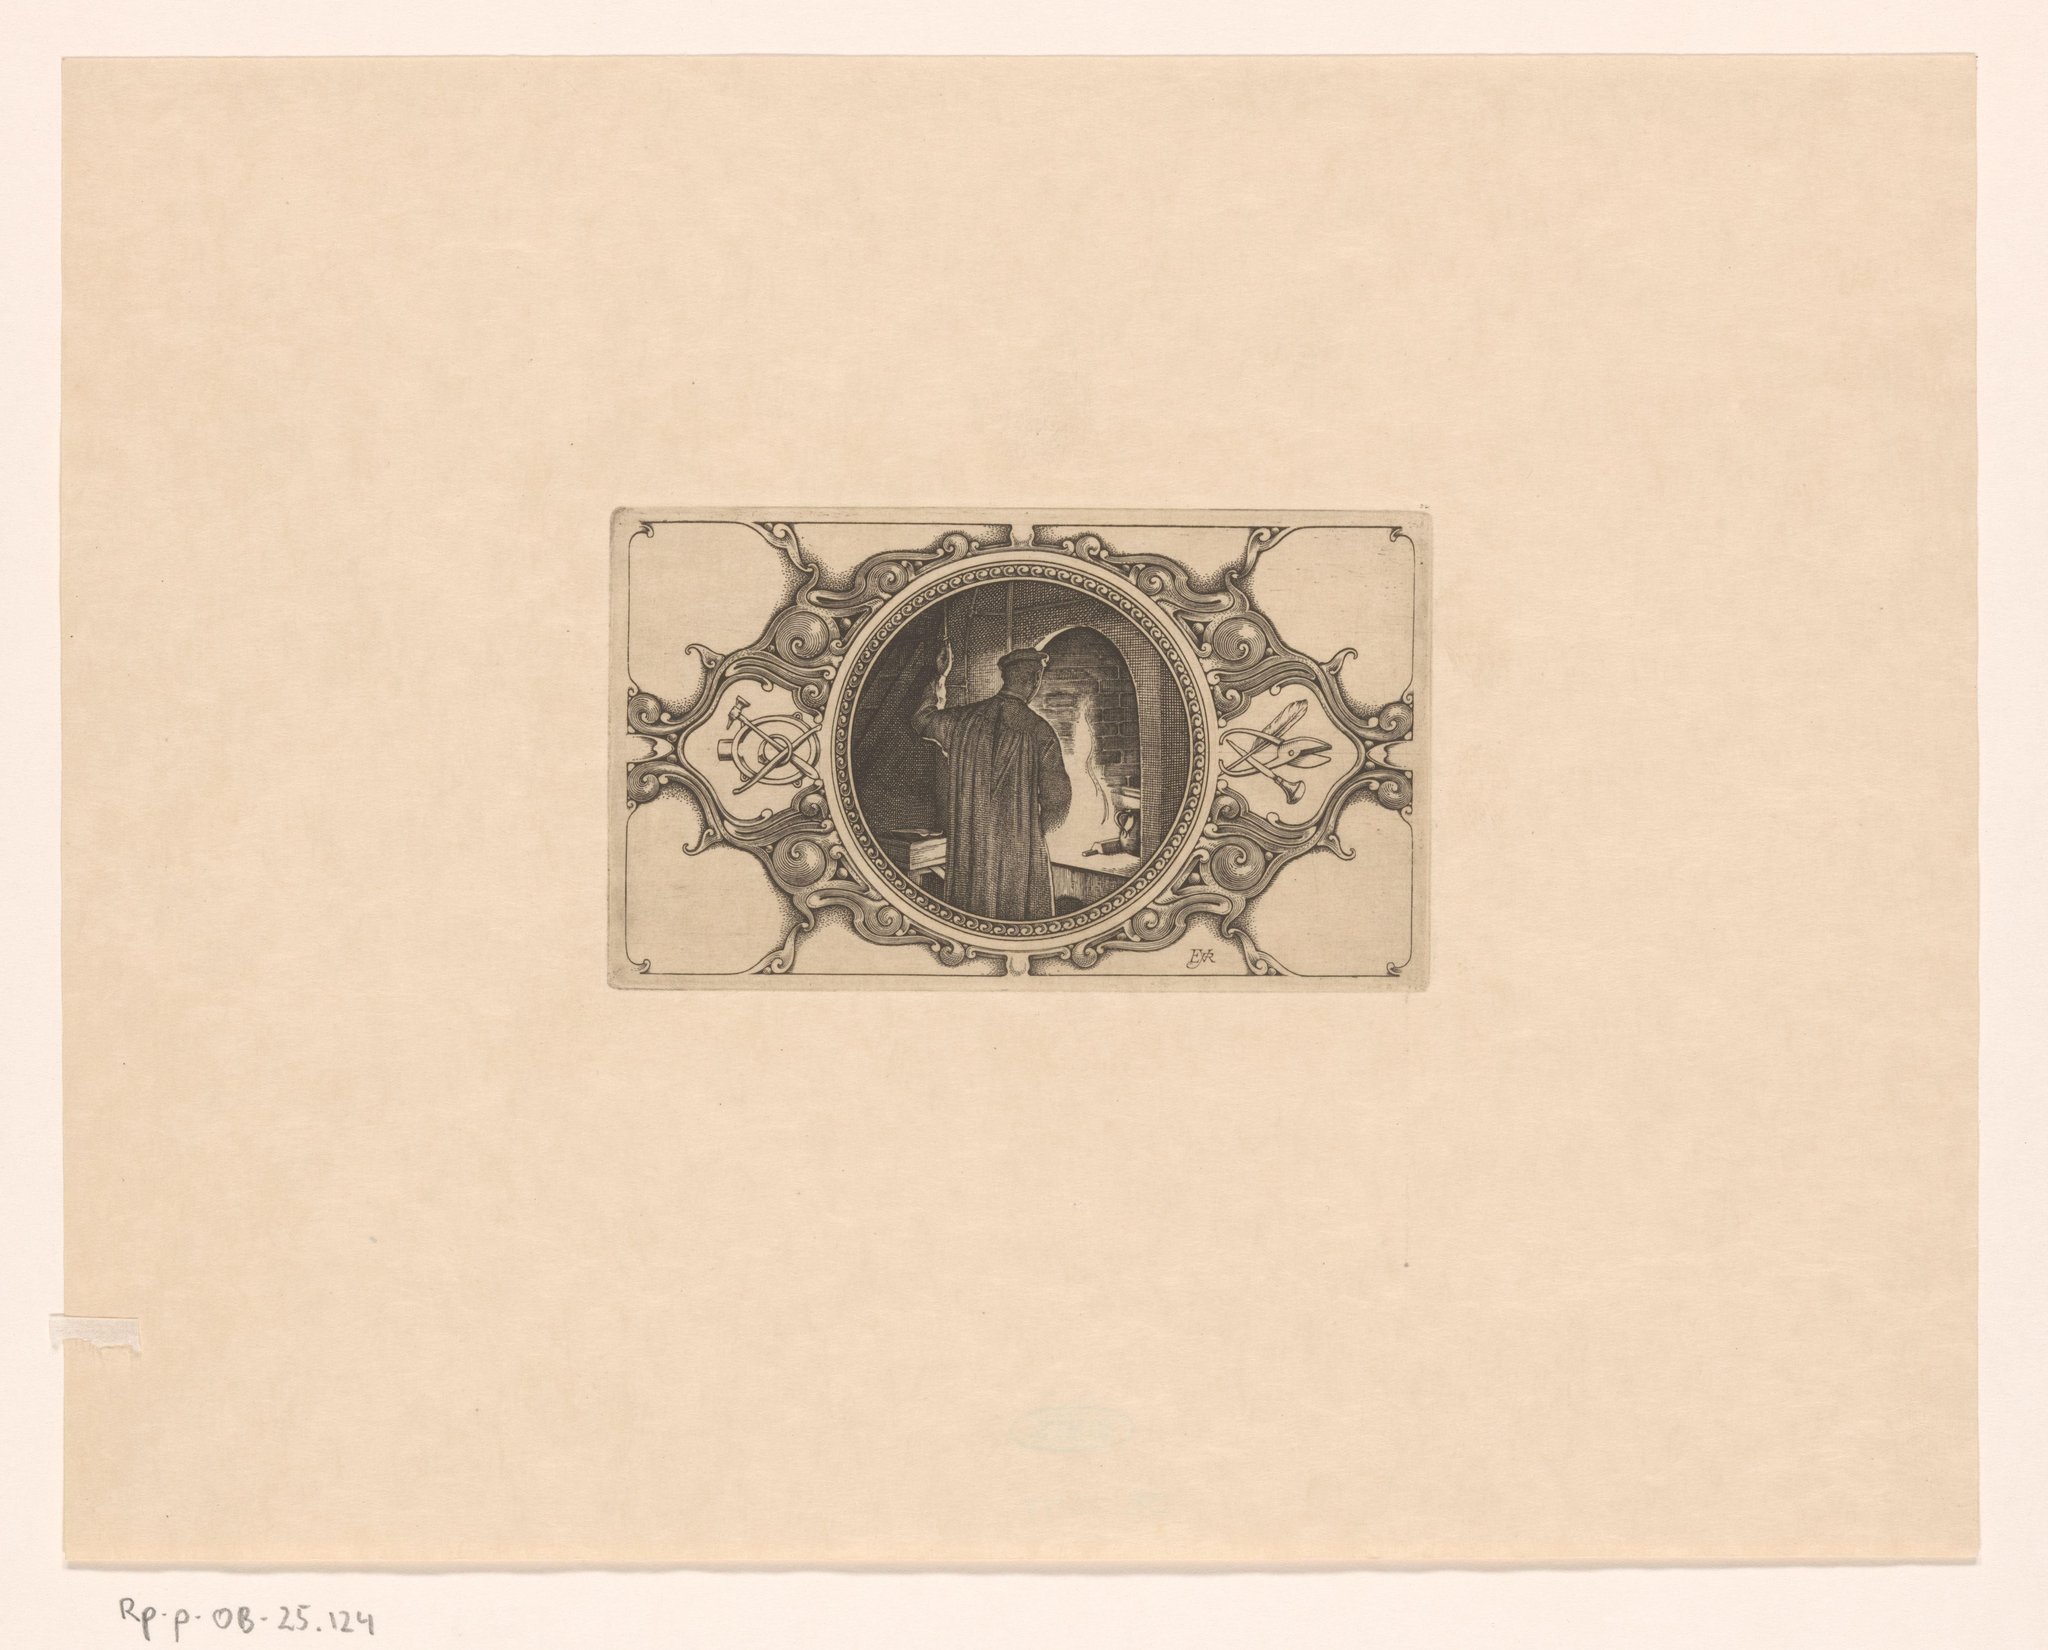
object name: print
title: Goudsmidswerkplaats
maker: elias voet jr.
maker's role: jeweler, print maker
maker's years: 1868-1940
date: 1878-1940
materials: paper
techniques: engraving, intaglio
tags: tools, implements of craftsman, smith, blacksmith, vignette, open fire, fire-place, stove (in kitchen)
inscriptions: collector's mark: Lugt 2228